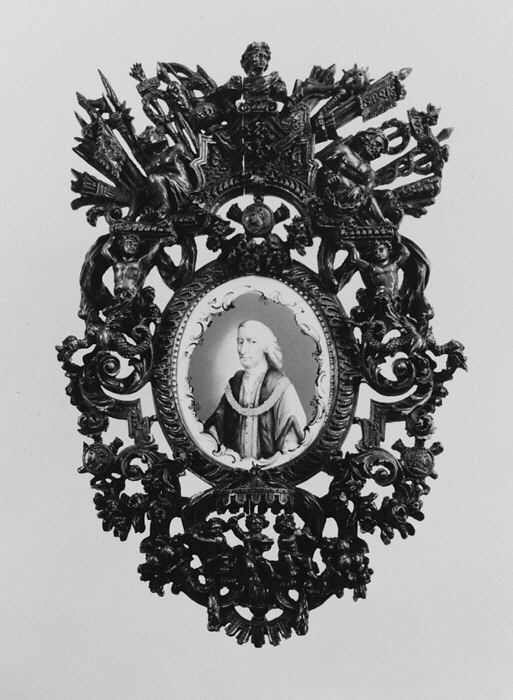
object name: frame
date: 1701-1800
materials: wood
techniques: carving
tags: men,portraits